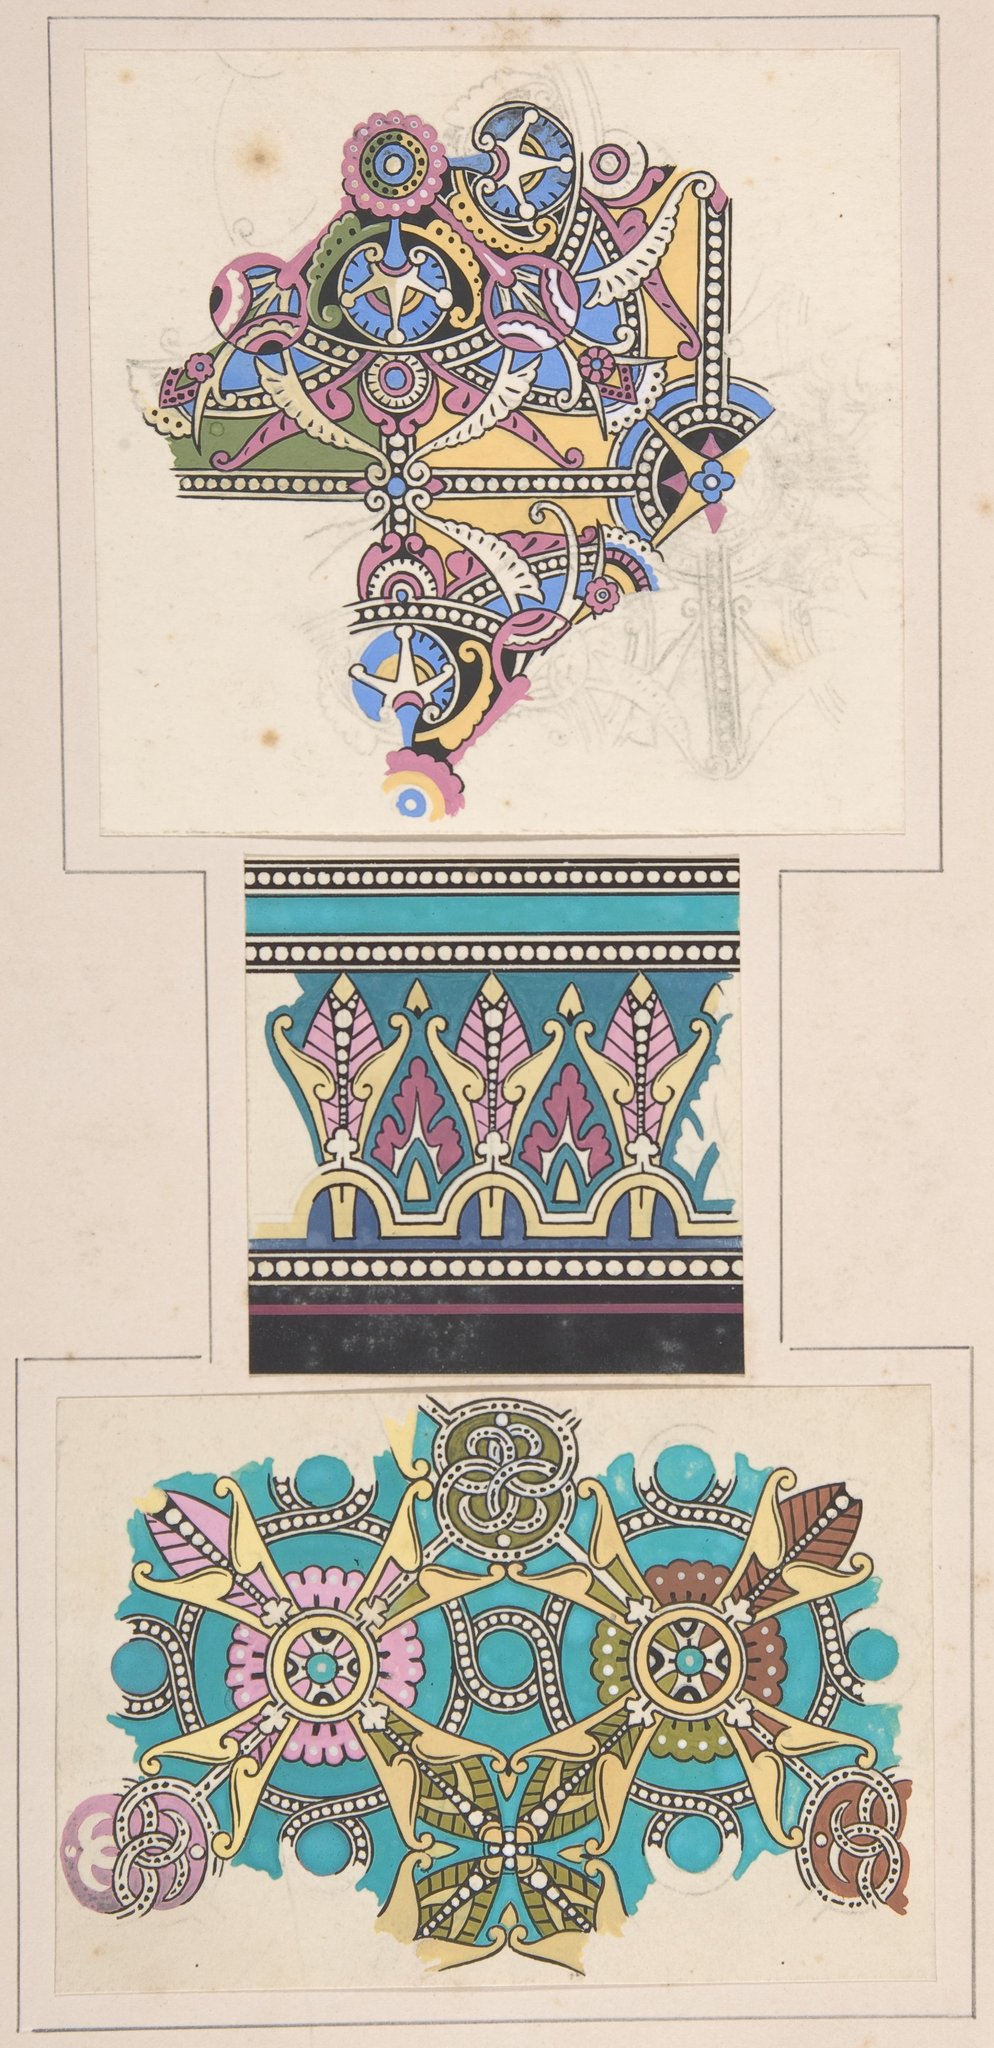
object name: drawing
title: Design drawing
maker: christopher dresser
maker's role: designer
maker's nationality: british, scottish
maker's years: 1834-1904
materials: gouache, graphite, ink